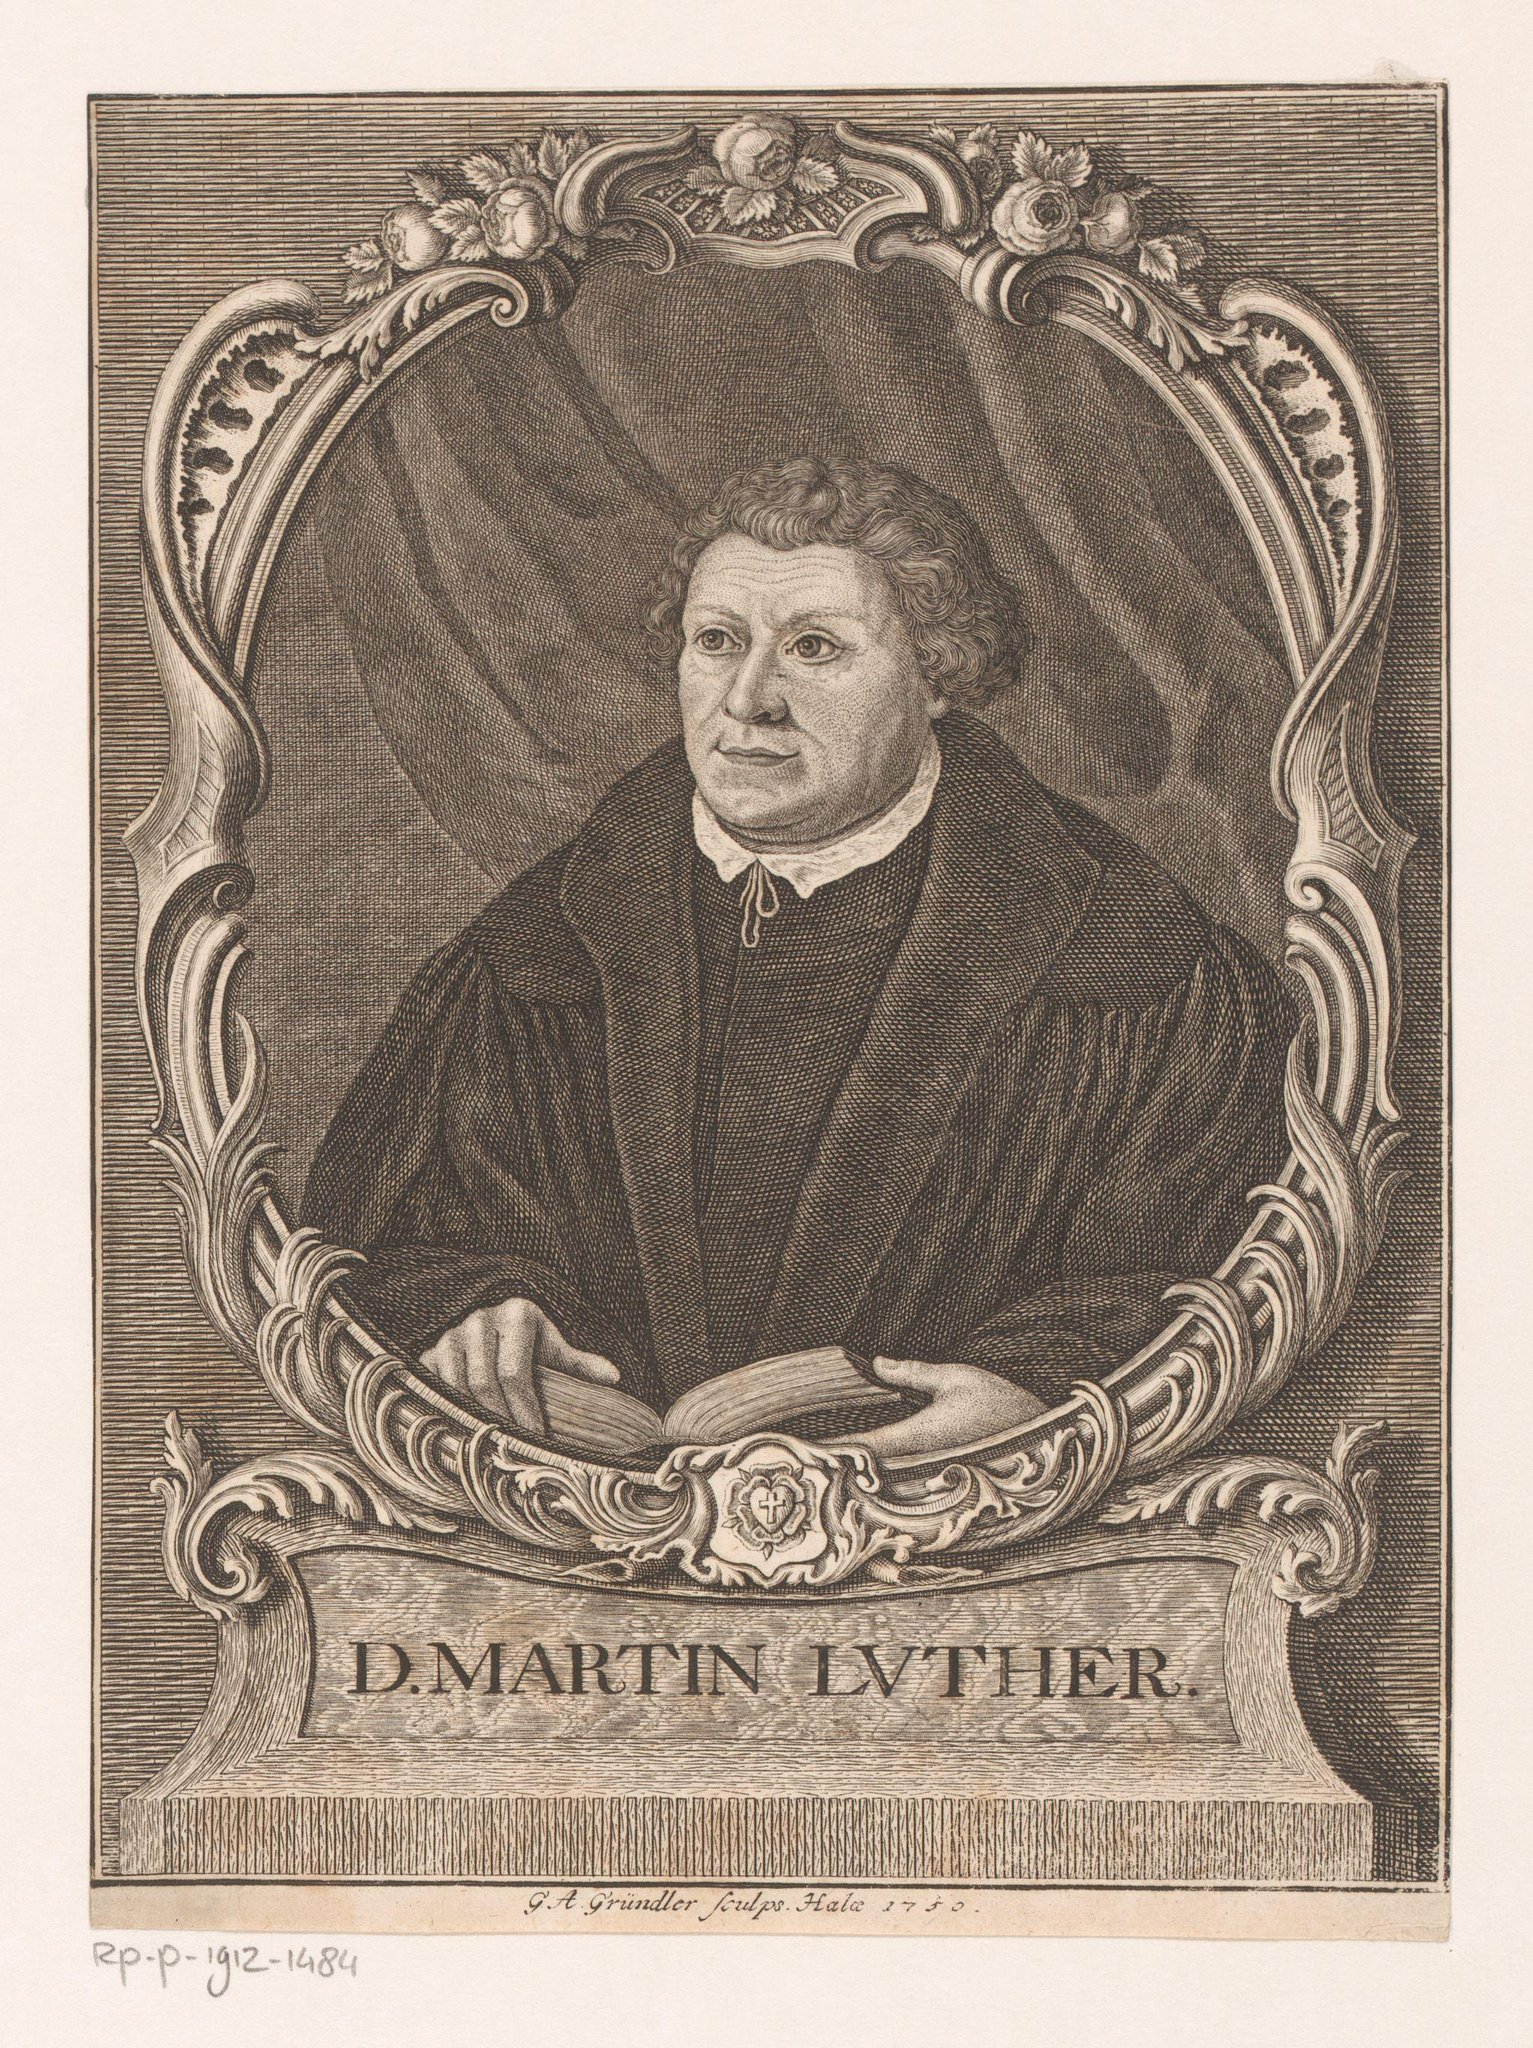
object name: print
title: Portret van Martin Luther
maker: gottfried august gründler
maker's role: painter, print maker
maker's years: 1710-1775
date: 1750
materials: paper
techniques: engraving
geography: halle an der saale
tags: priest, martin luther, theologian, ornament ~ medallion, historical persons, book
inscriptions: collector's mark: Lugt 2228